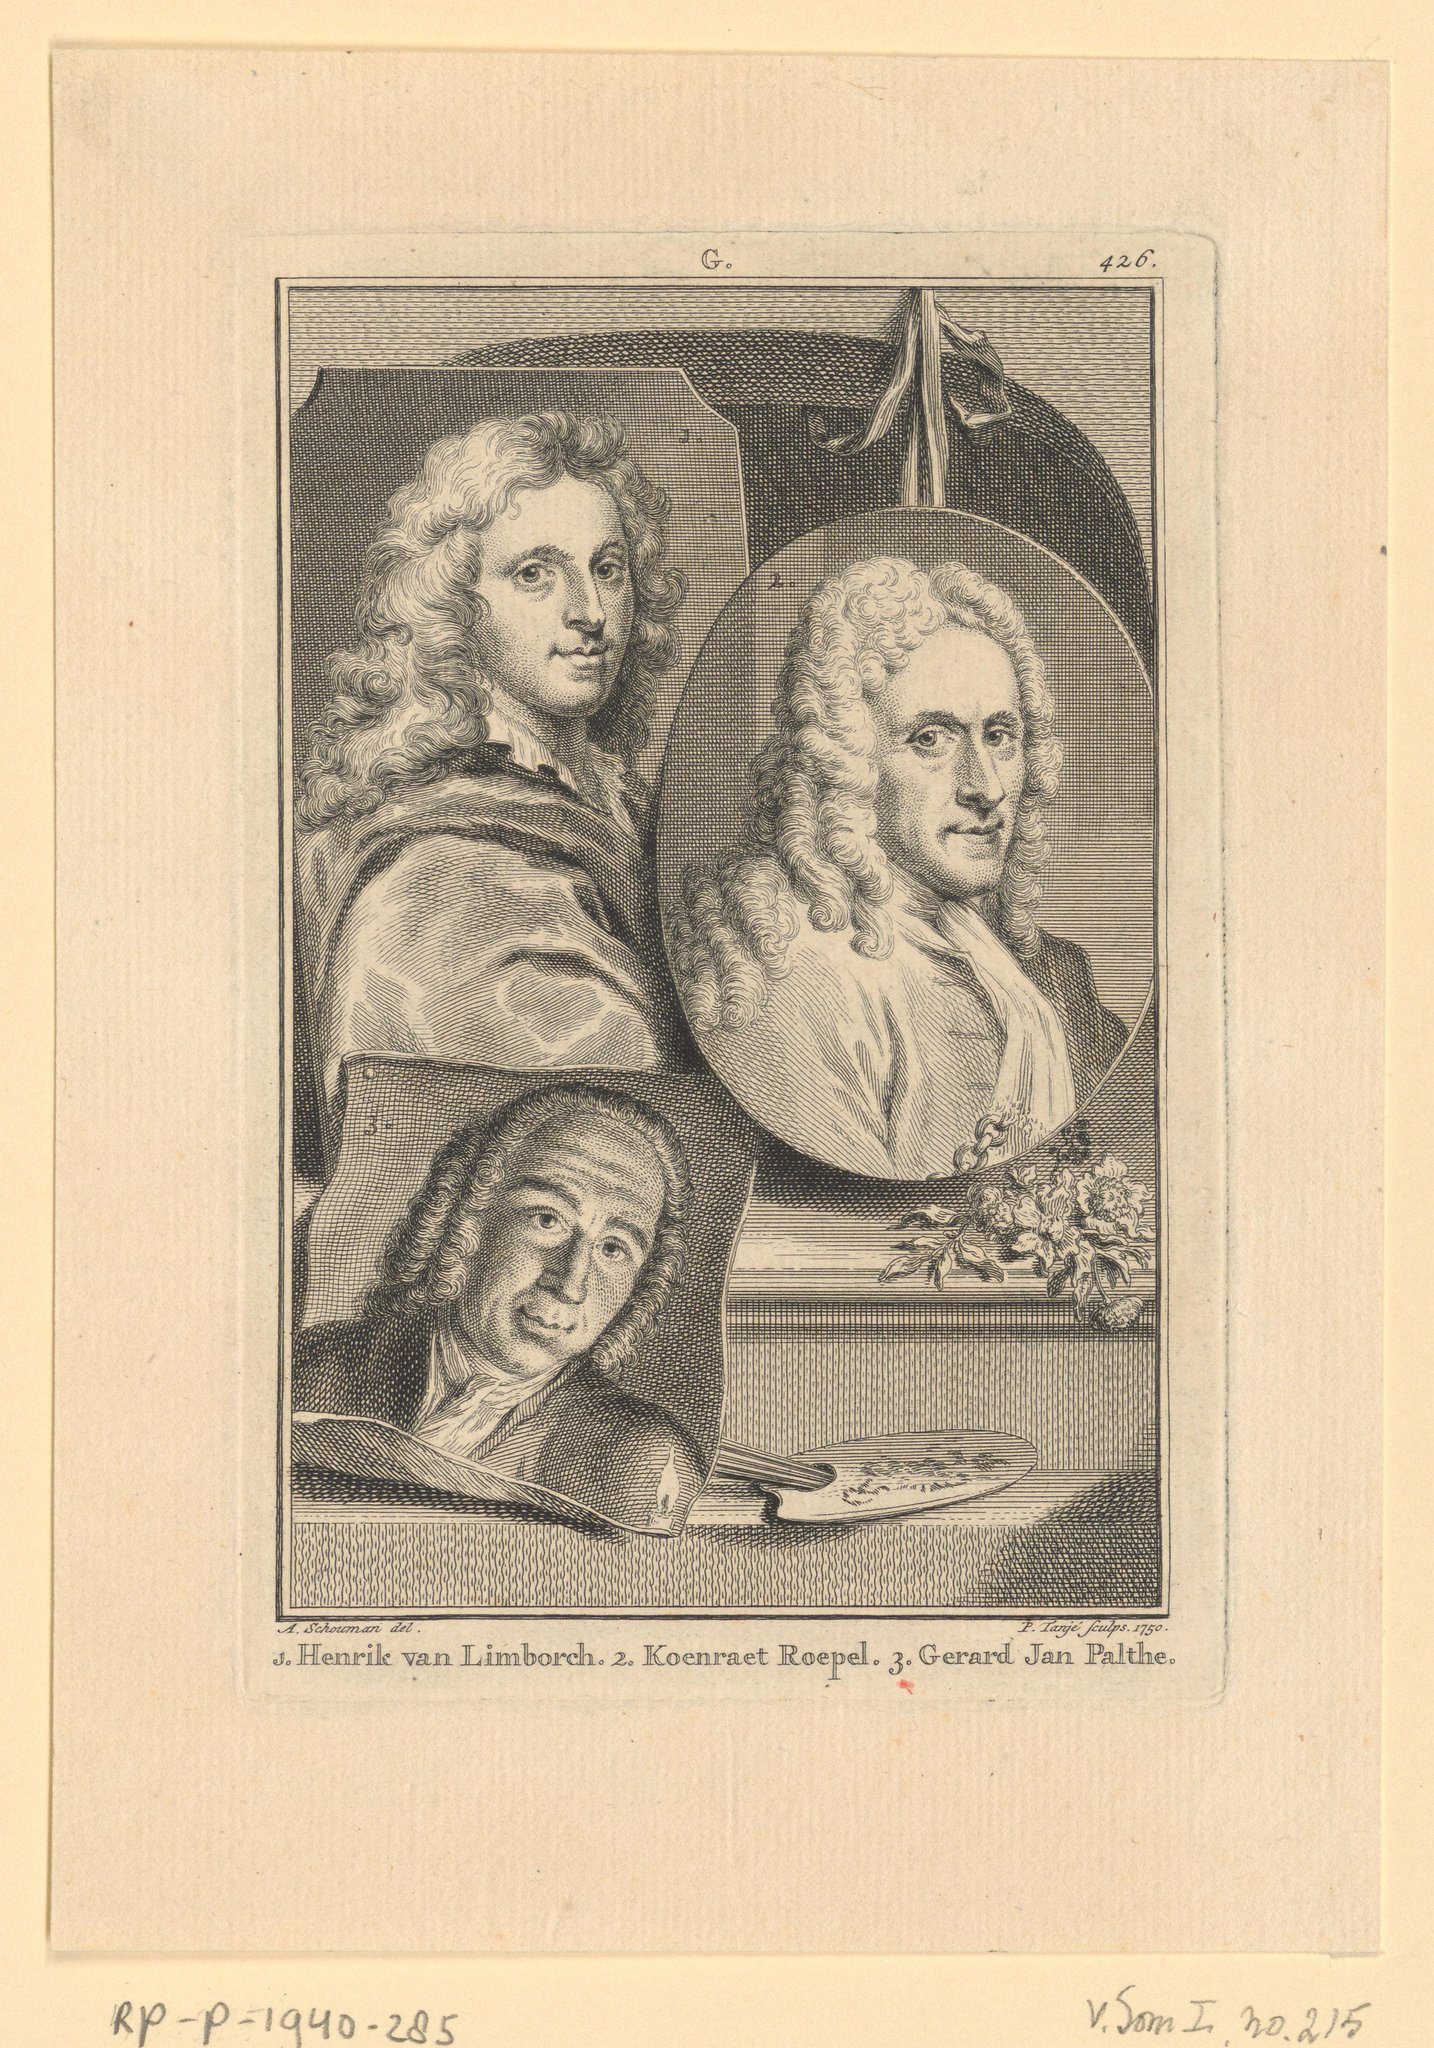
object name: book illustration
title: Portretten van Hendrik van Limborch, Coenraet Roepel en Gerhard Jan Palthe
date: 1750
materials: paper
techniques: engraving, etching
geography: amsterdam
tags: the hague, painter, print maker, draughtsman, hendrik van limborch, coenraet roepel, deventer, gerhard jan palthe, ornament ~ medallion, historical persons, portrait, self-portrait of artist, palette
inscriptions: collector's mark: Lugt 2228, inscription: ‘JV Gool’, collector's mark: Lugt 2760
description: Prent waarschijnlijk uit: Gool, Johan van. De nieuwe schouburg der Nederlantsche kunstschilders en schilderessen. Den Haag 1750, dl. 1, p. 426.